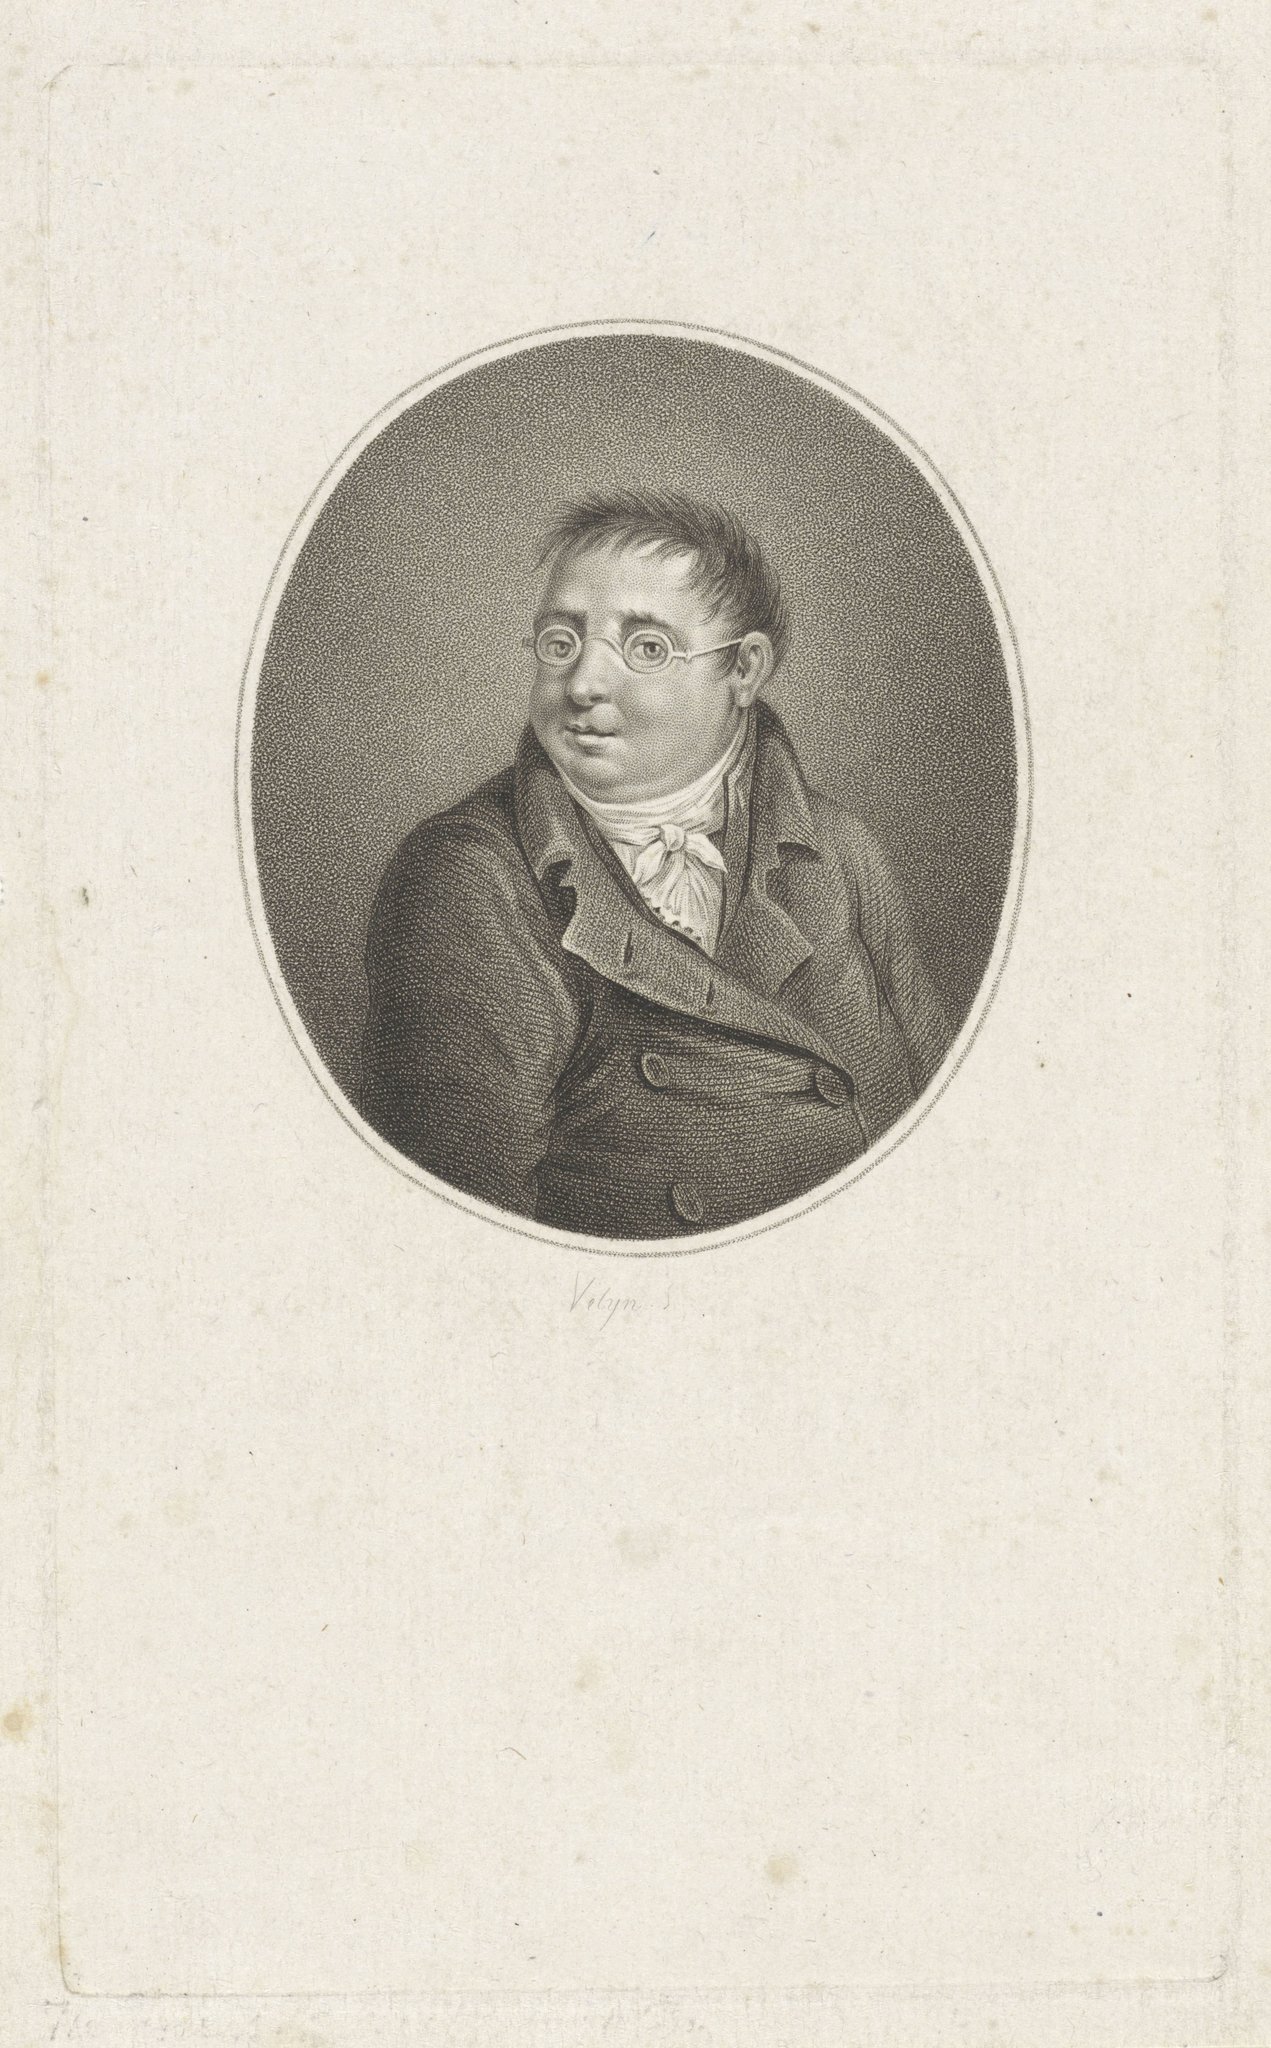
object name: print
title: Portret van Jan Fredrik Helmers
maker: philippus velijn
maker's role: print maker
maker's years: 1787-1836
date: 1797-1836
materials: paper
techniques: engraving, etching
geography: netherlands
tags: amsterdam, jan frederik helmers, eyeglasses, spectacles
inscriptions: collector's mark: Lugt 2228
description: Portret van Jan Fredrik Helmers, dichter en koopman te Amsterdam.